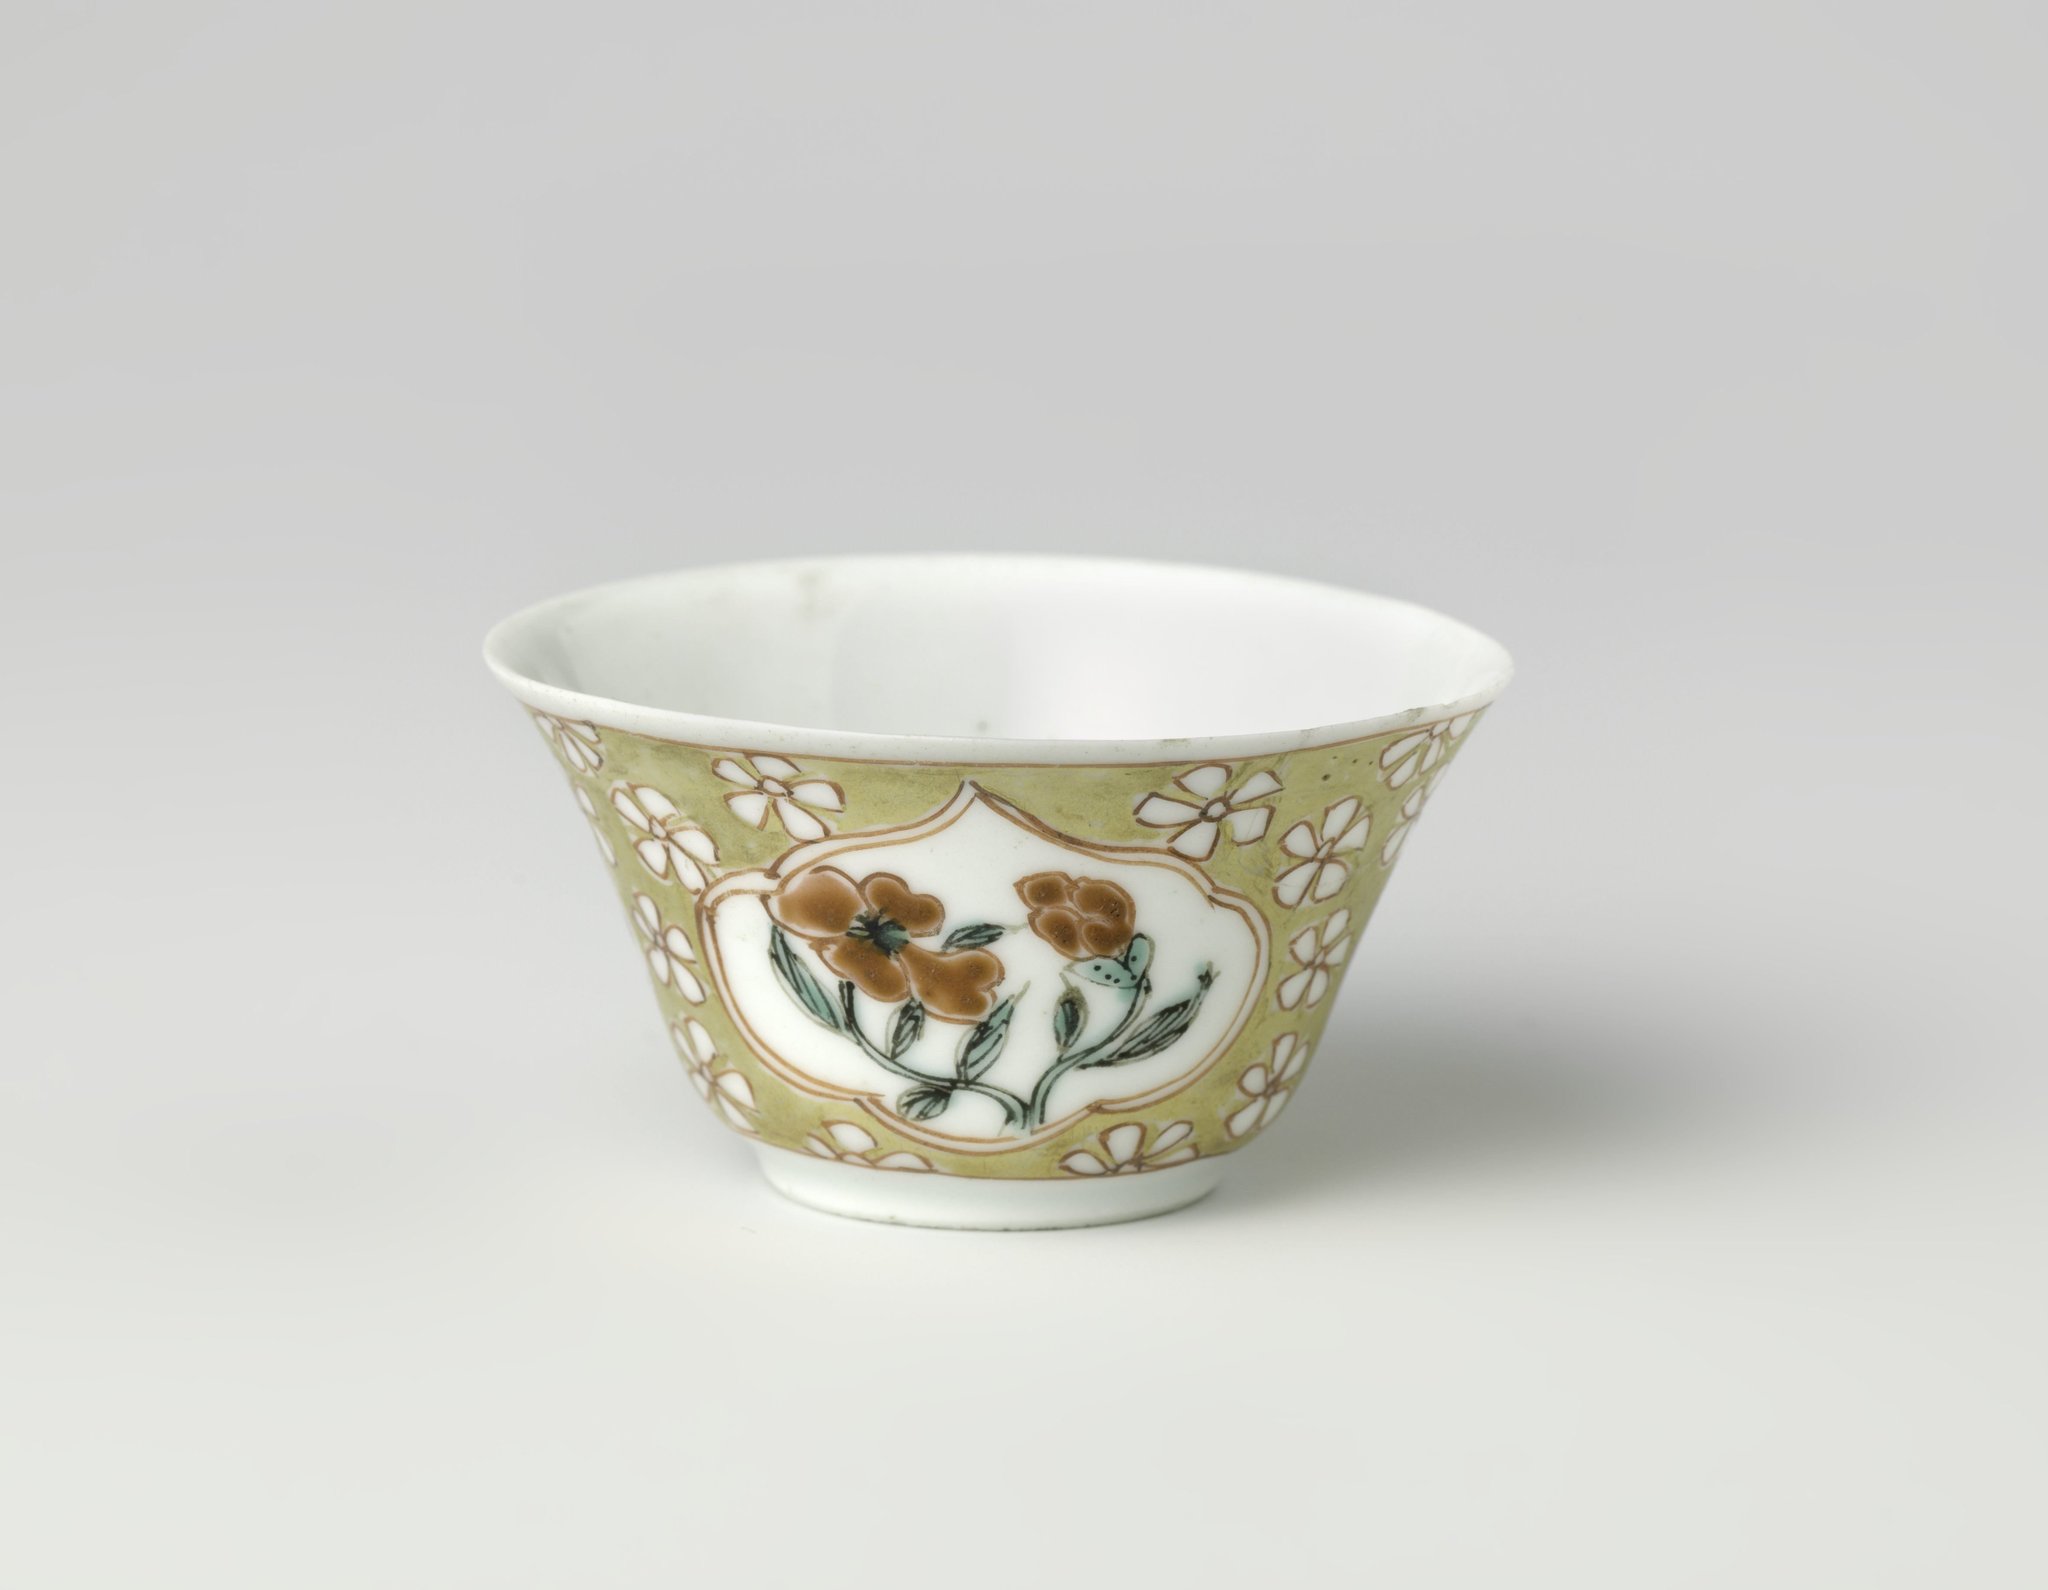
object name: cup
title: Cup with a farmer and flowering plants in panels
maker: Anonymous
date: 1725-1749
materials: glaze, gold, paint, porcelain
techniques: firing, gilding, turning, vitrification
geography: china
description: Kop van porselein met spreidende wand, beschilderd op het glazuur in rood, roze, groen, zwart en goud. Een medaillon met een werkende boer met een stok in het water bij een pijnboom en struiken afgebeeld; om het medaillon uitgespaarde, gestileerde bloemen en drie cartouches met bloeiende planten tegen een gouden grond. Kop is gebroken geweest. Famille rose.